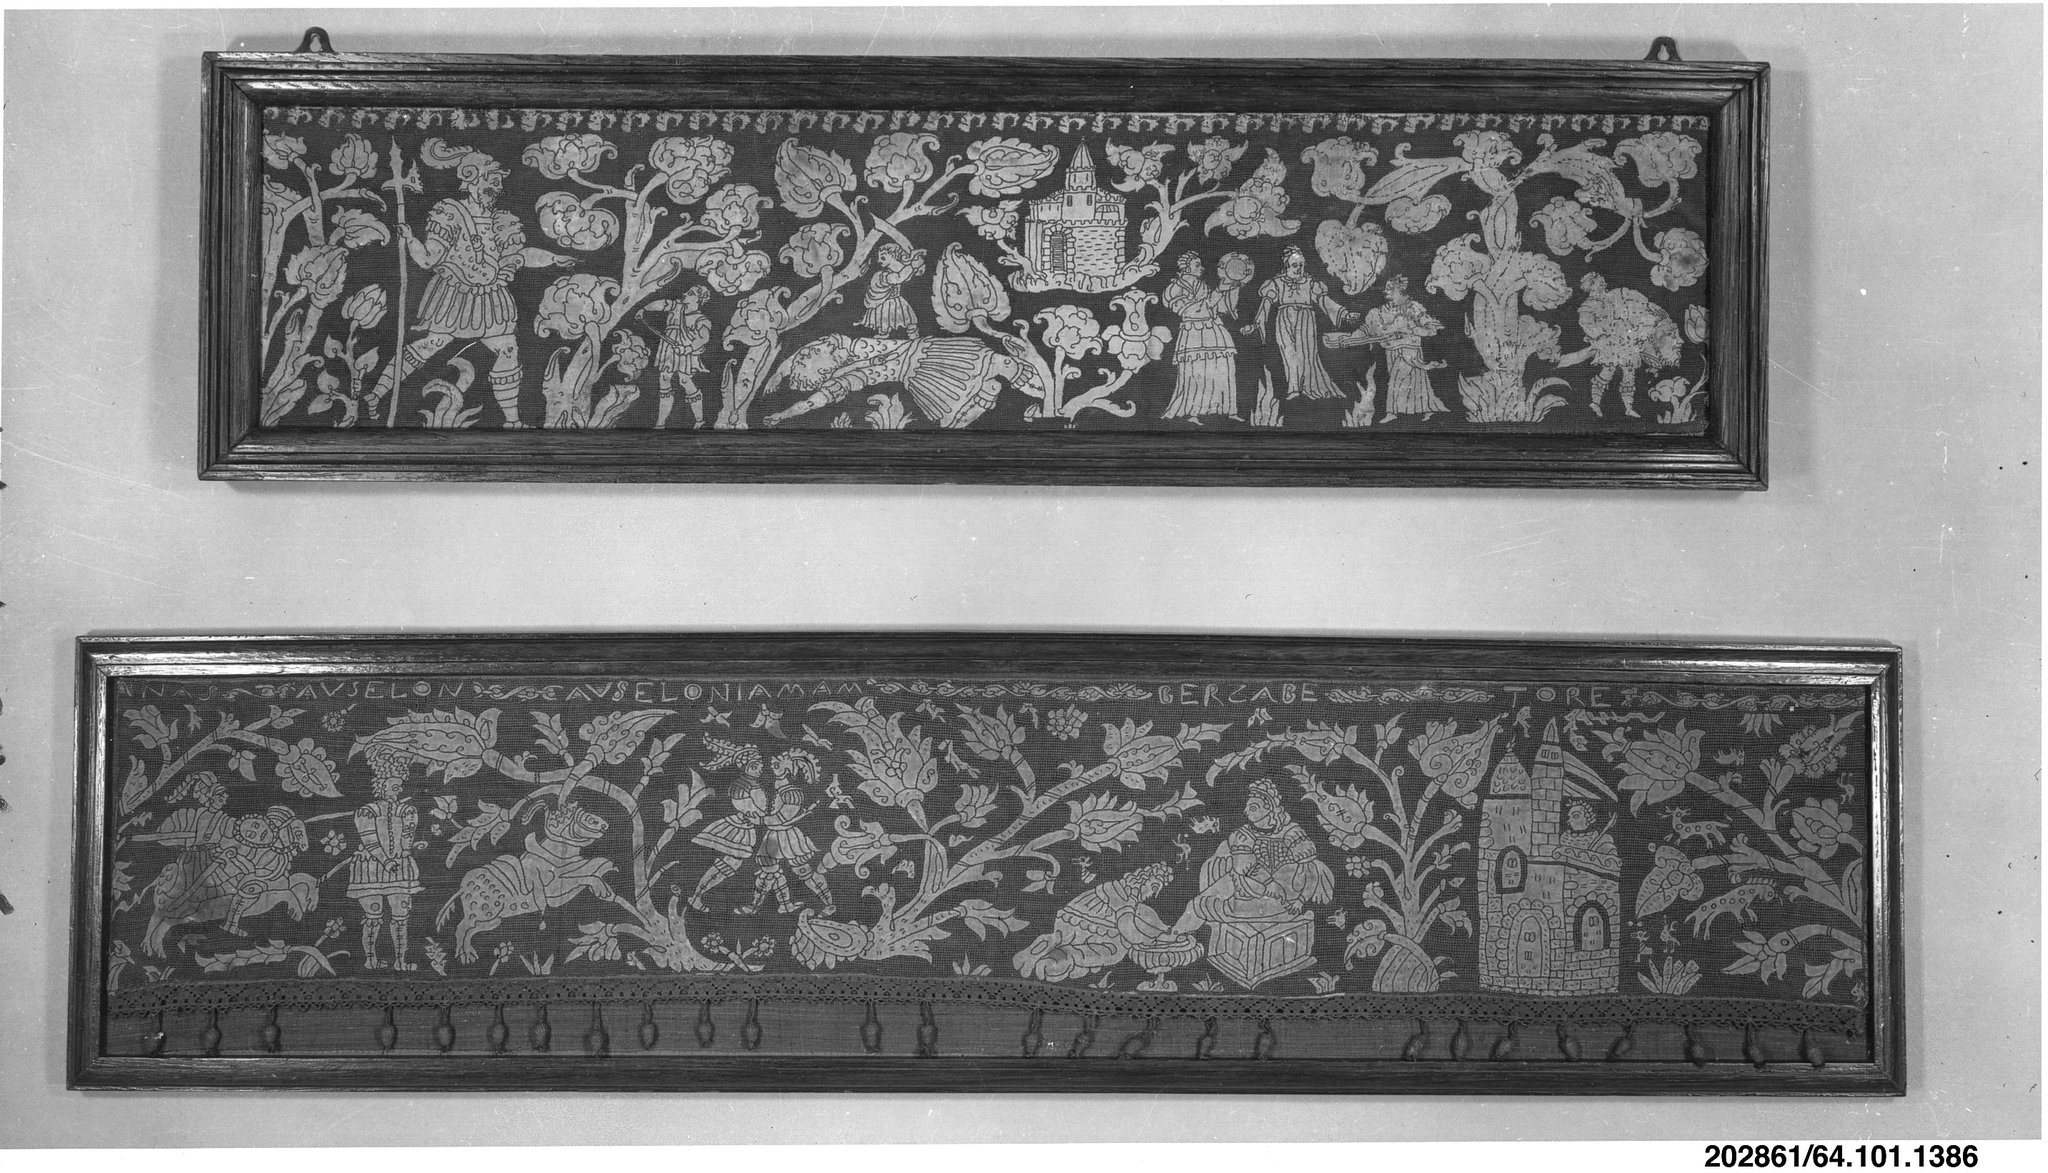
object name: band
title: Band with scenes from the Story of David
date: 1601-1650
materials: linen, silk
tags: human figures,animals,horses,flowers,david